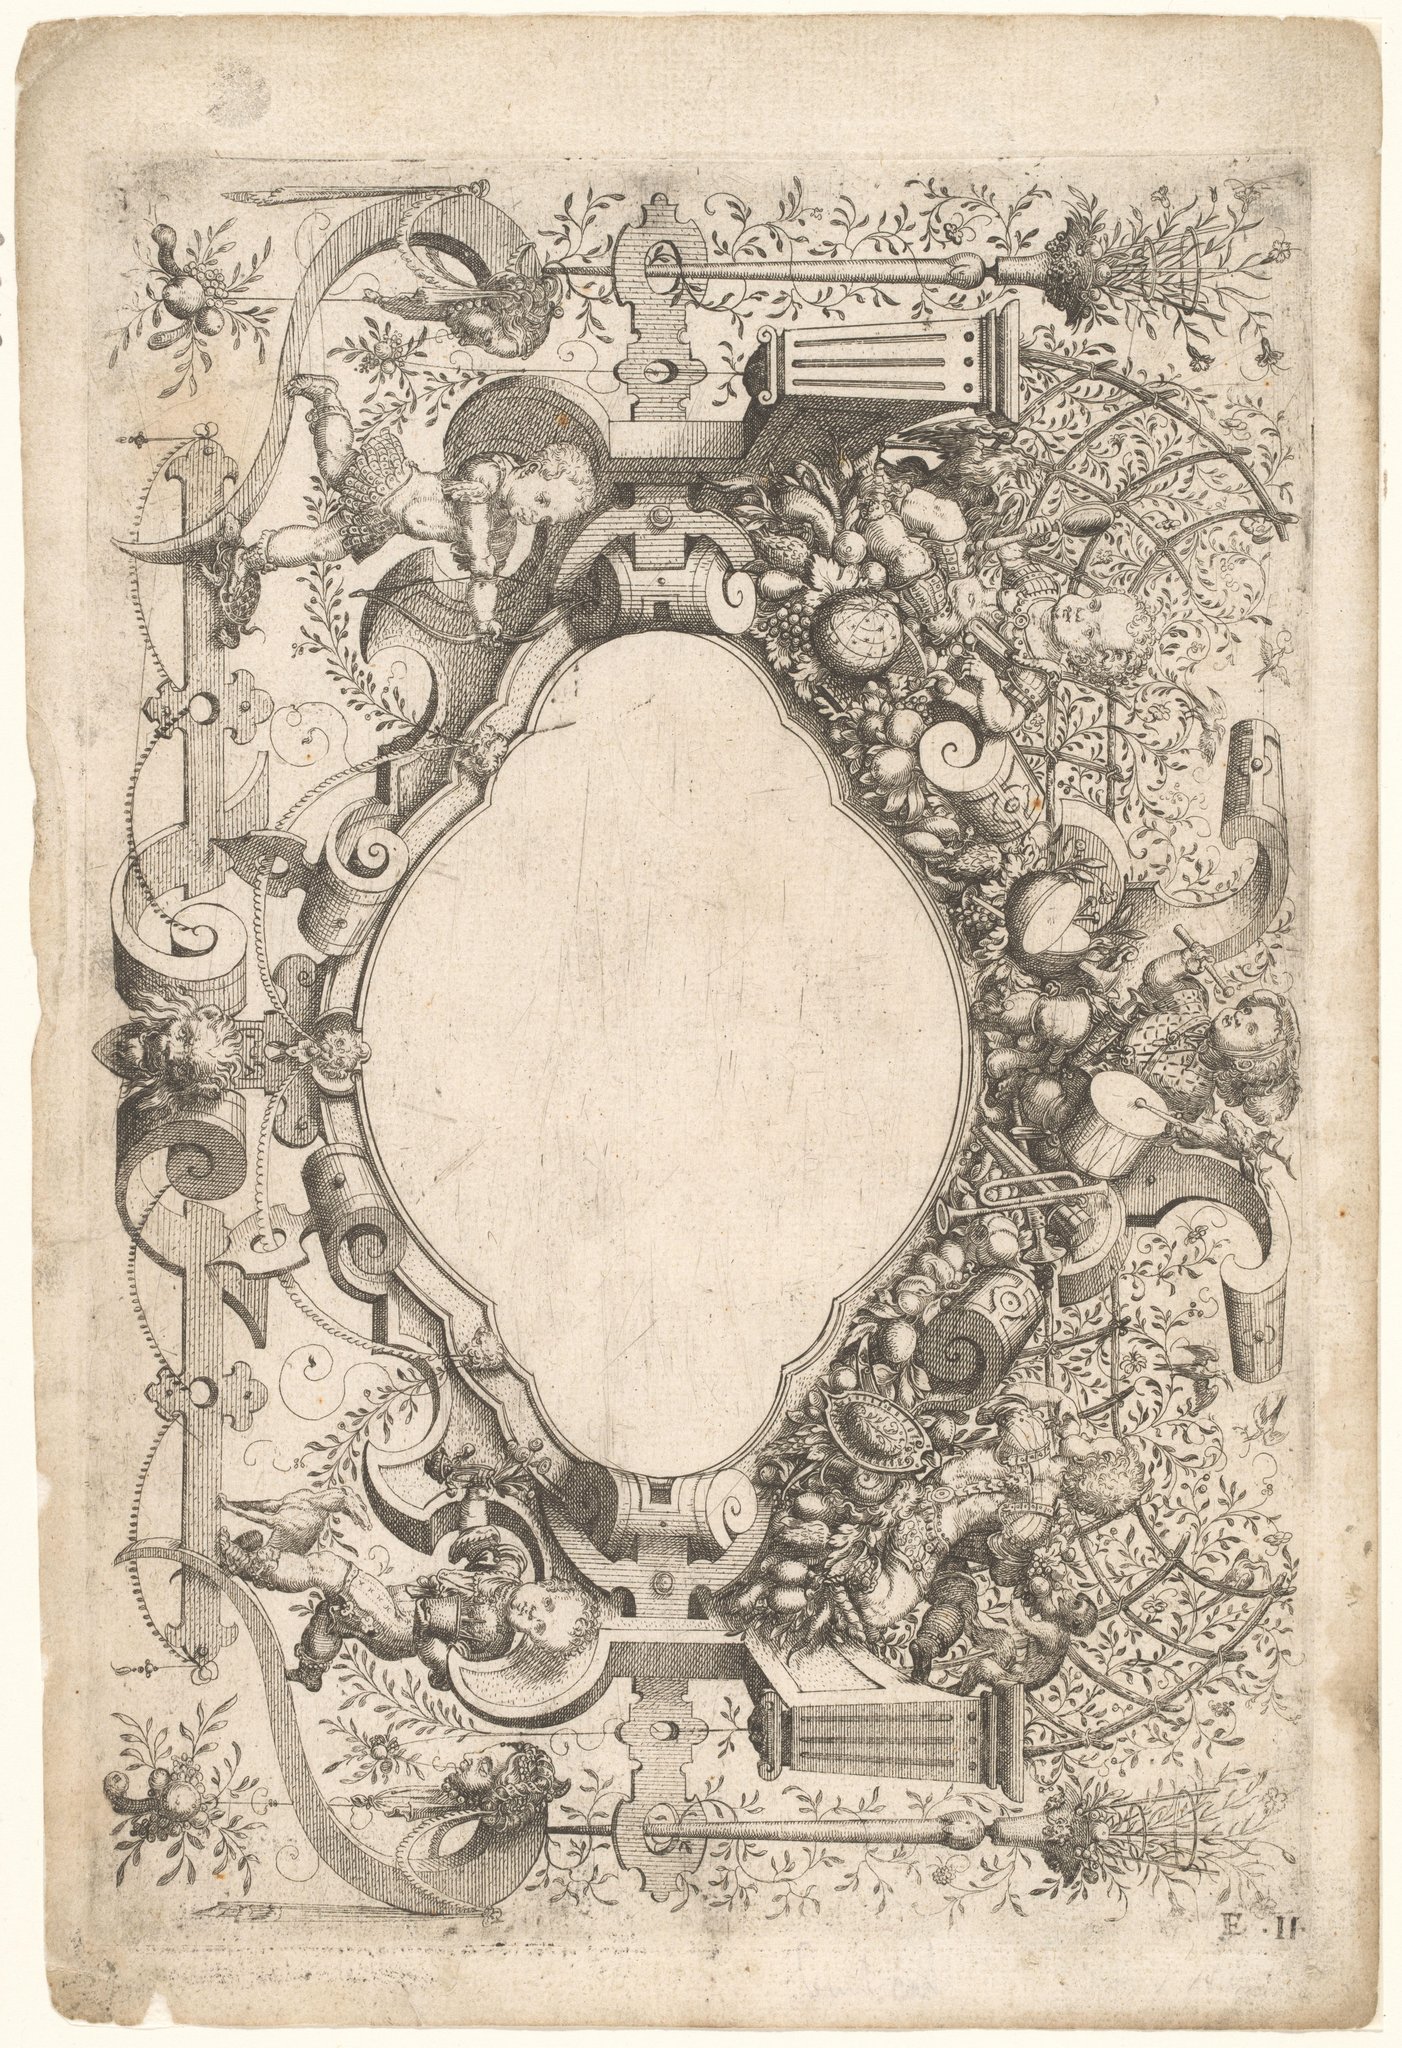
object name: book illustration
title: Titelcartouche voor: Wenzel Jamnitzer, Perspectiva corporum regularium, 1568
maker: jost amman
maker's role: draughtsman, painter, print maker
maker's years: 1539-1591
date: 1568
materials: paper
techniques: engraving, etching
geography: nuremberg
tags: ornament derived from animal forms, tortoises, turtles, monkeys, apes, birds, archer's weapons: bow, ornament ~ cartouche, ornament derived from plant forms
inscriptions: signature: ‘IA’, collector's mark: Lugt 2228, collector's mark: Lugt 2760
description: Centraal een cartouche in een versierde omlijsting met rolwerk waarin vijf kindertjes spelen tussen planten en dieren, mascarons en bloempotten. Bovenaan een begroeide latwerk met ranken en vogels. Proefdruk zonder tekst van een titelpagina in Wenzel Jamnitzer, Perspectiva corporum regularium.